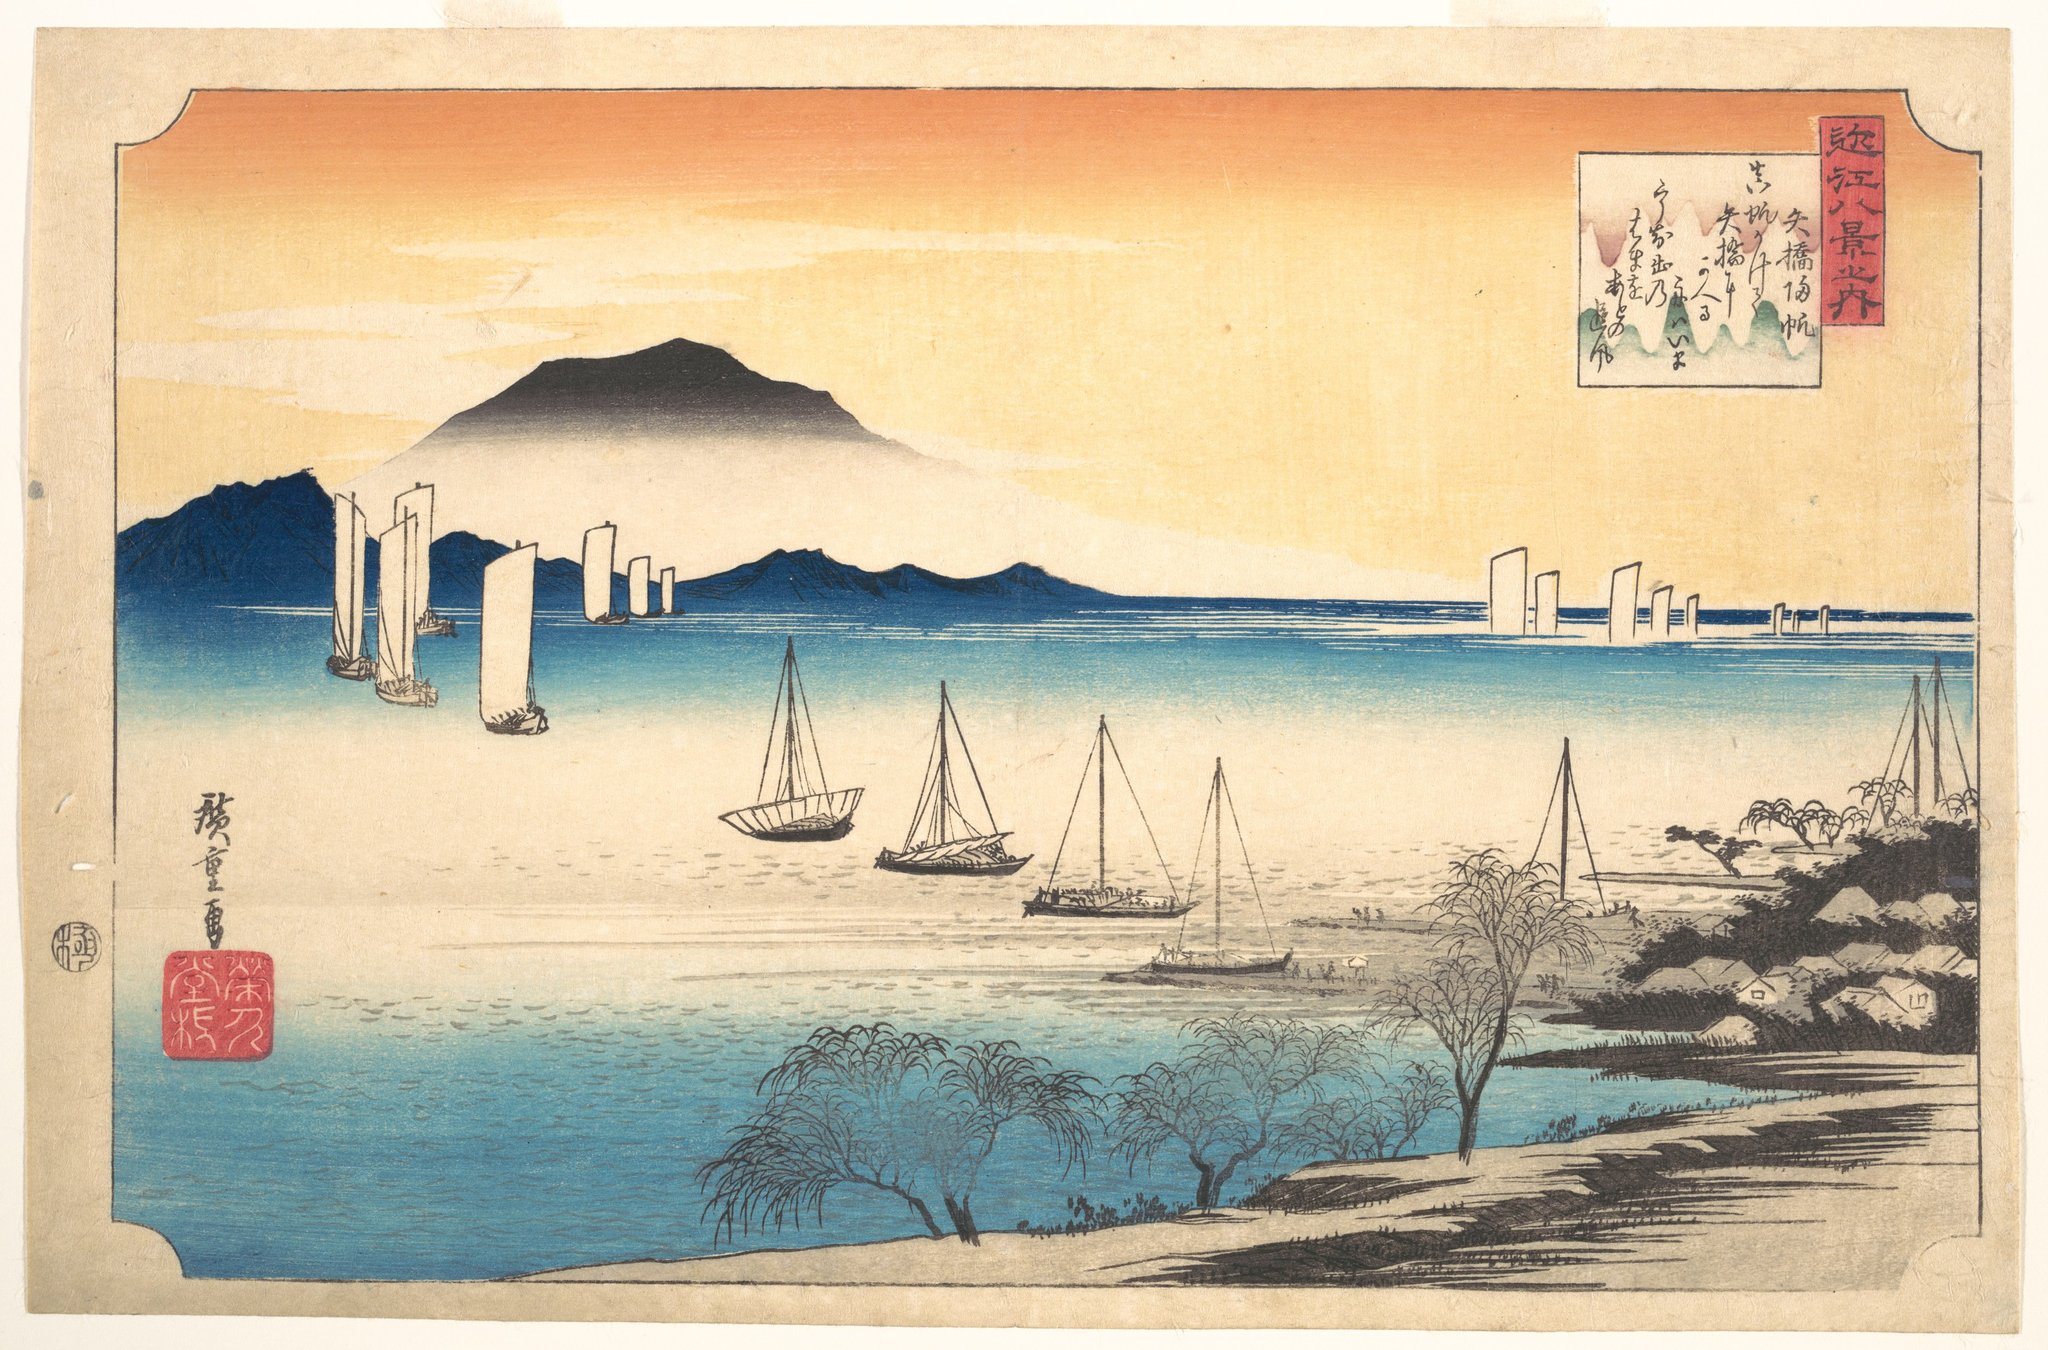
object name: woodblock print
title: Fishing Boats Returning to Yabase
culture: japanese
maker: utagawa hiroshige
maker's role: artist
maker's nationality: japanese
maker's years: 1797-1858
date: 1797-1858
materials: ink, paper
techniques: woodblock print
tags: lakes,mountains,boats